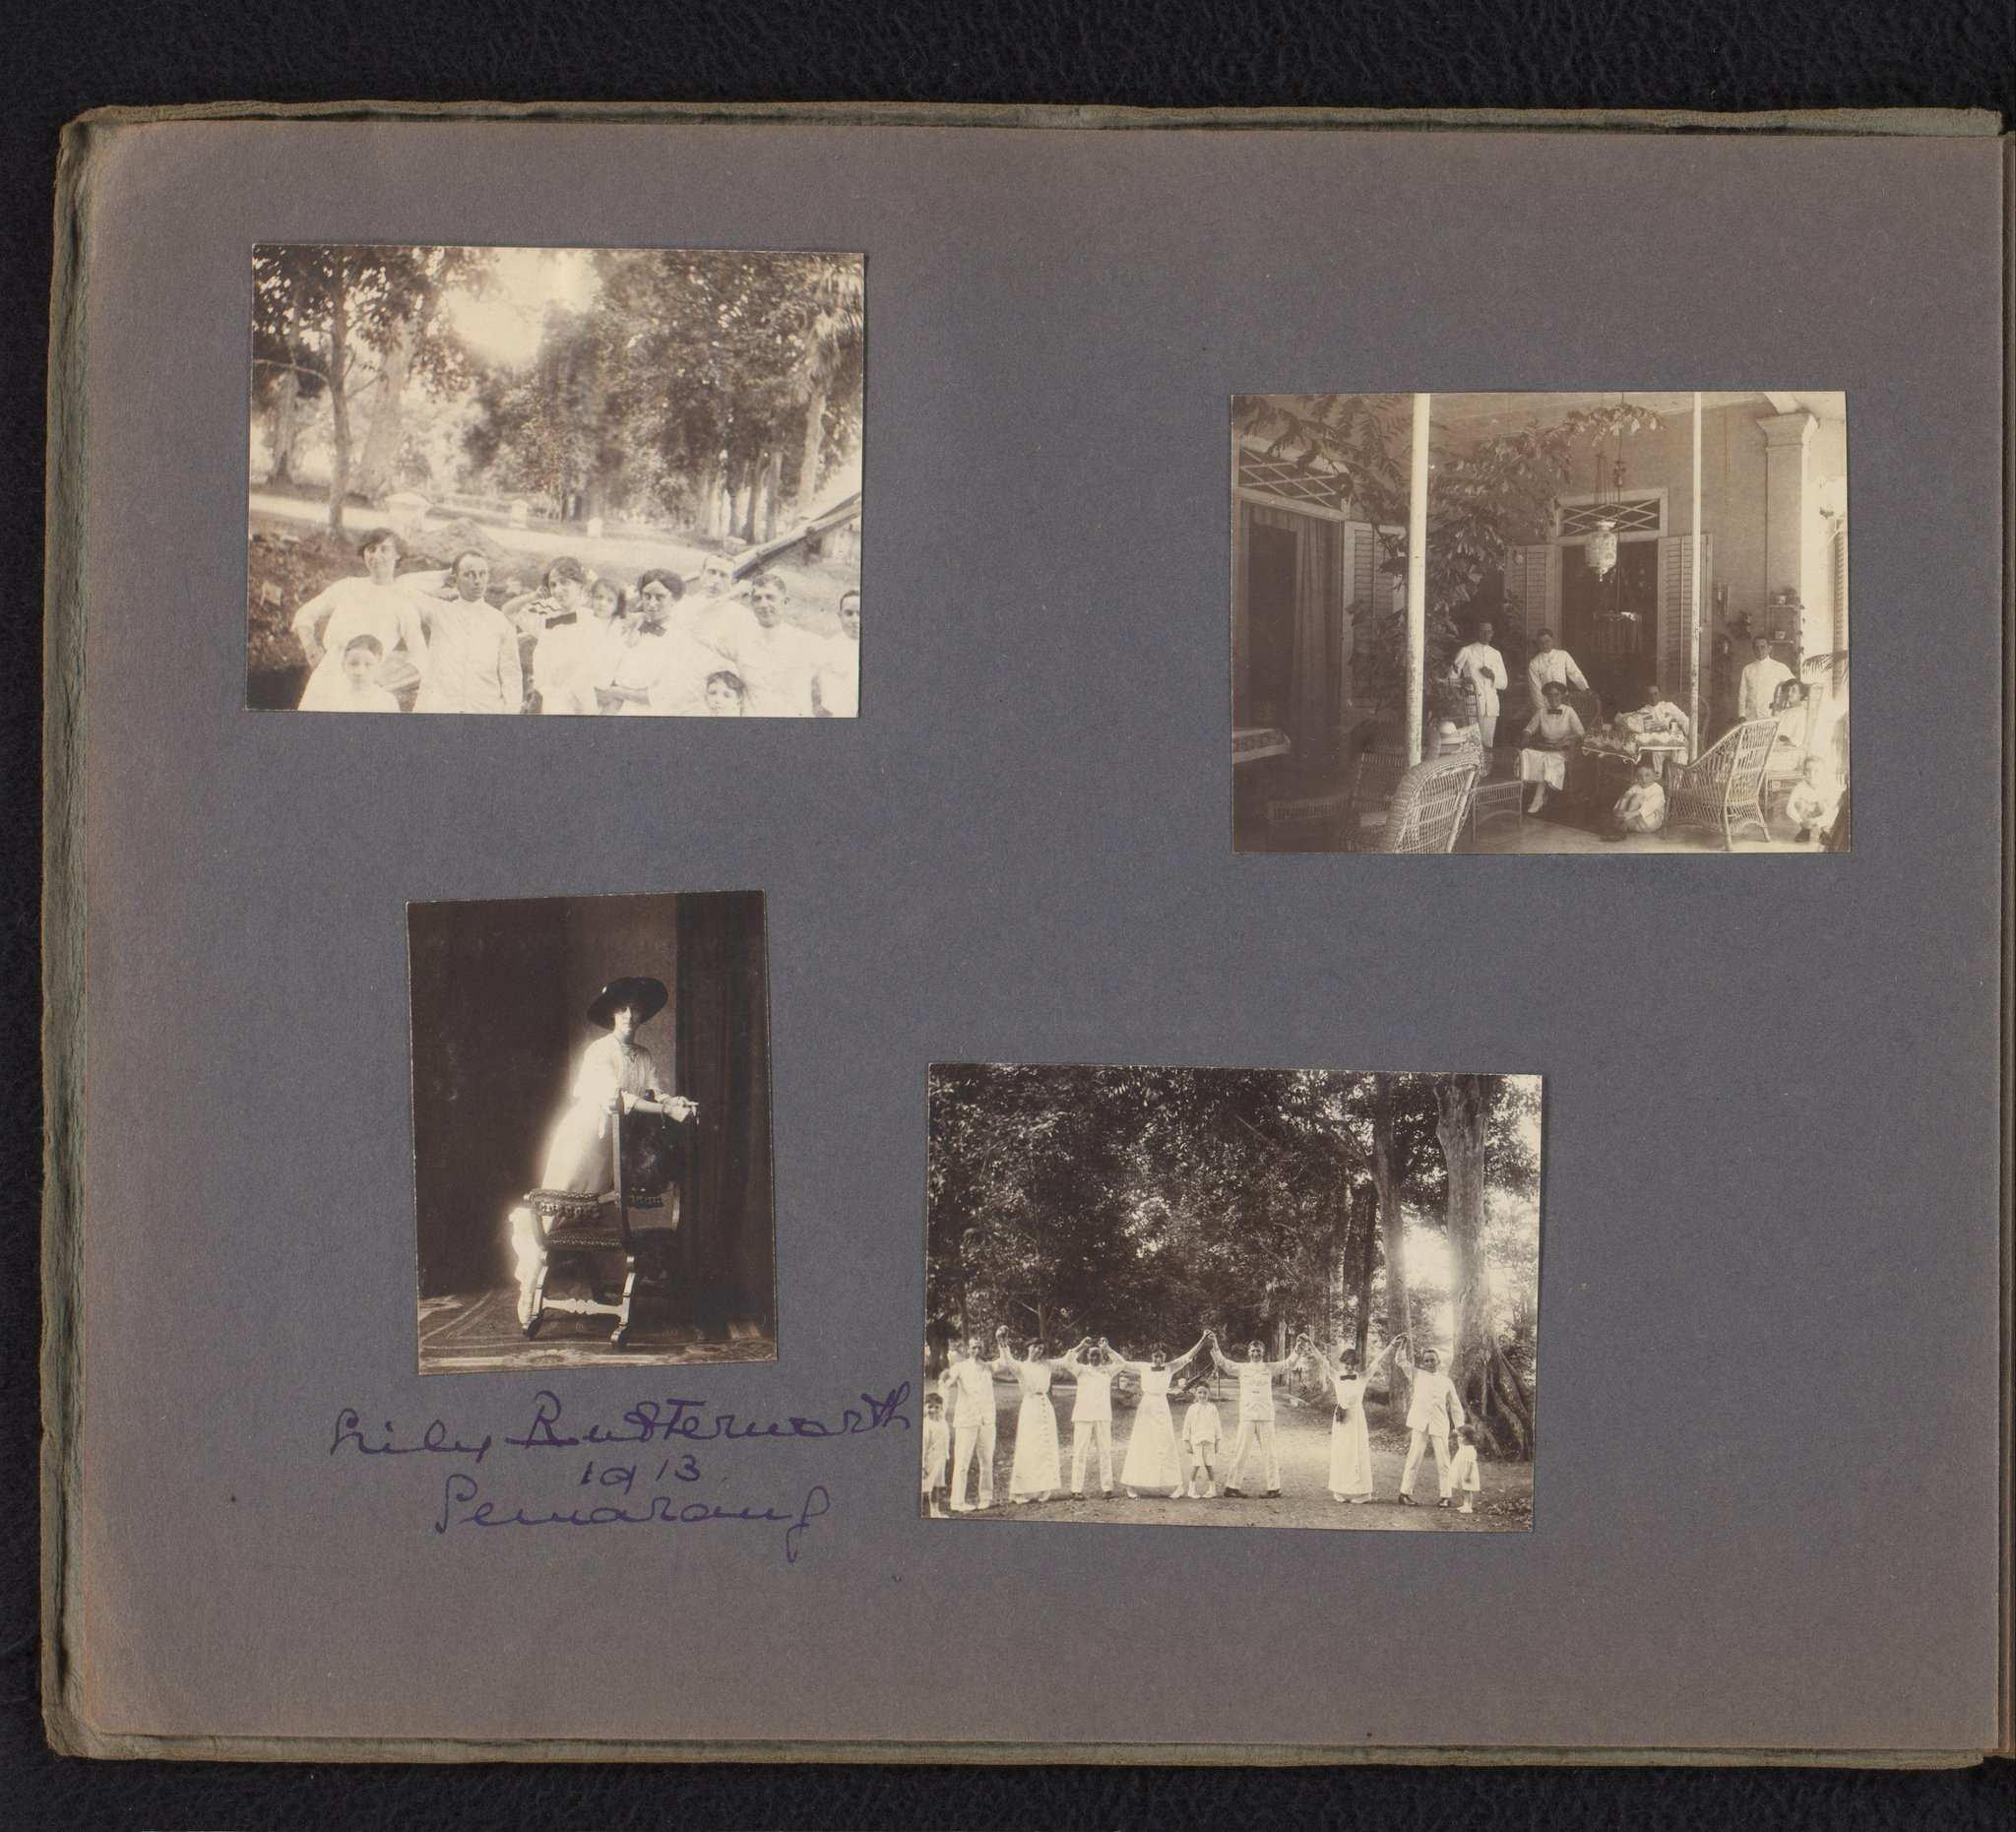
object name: album leaf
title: Europese mensen in Semarang, links onder Lily Rusterworth [?]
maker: Anonymous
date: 1913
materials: paper, cardboard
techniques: gelatin silver print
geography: semarang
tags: historical persons - bb - woman, anonymous historical person portrayed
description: Deze foto's zijn onderdeel van een album.